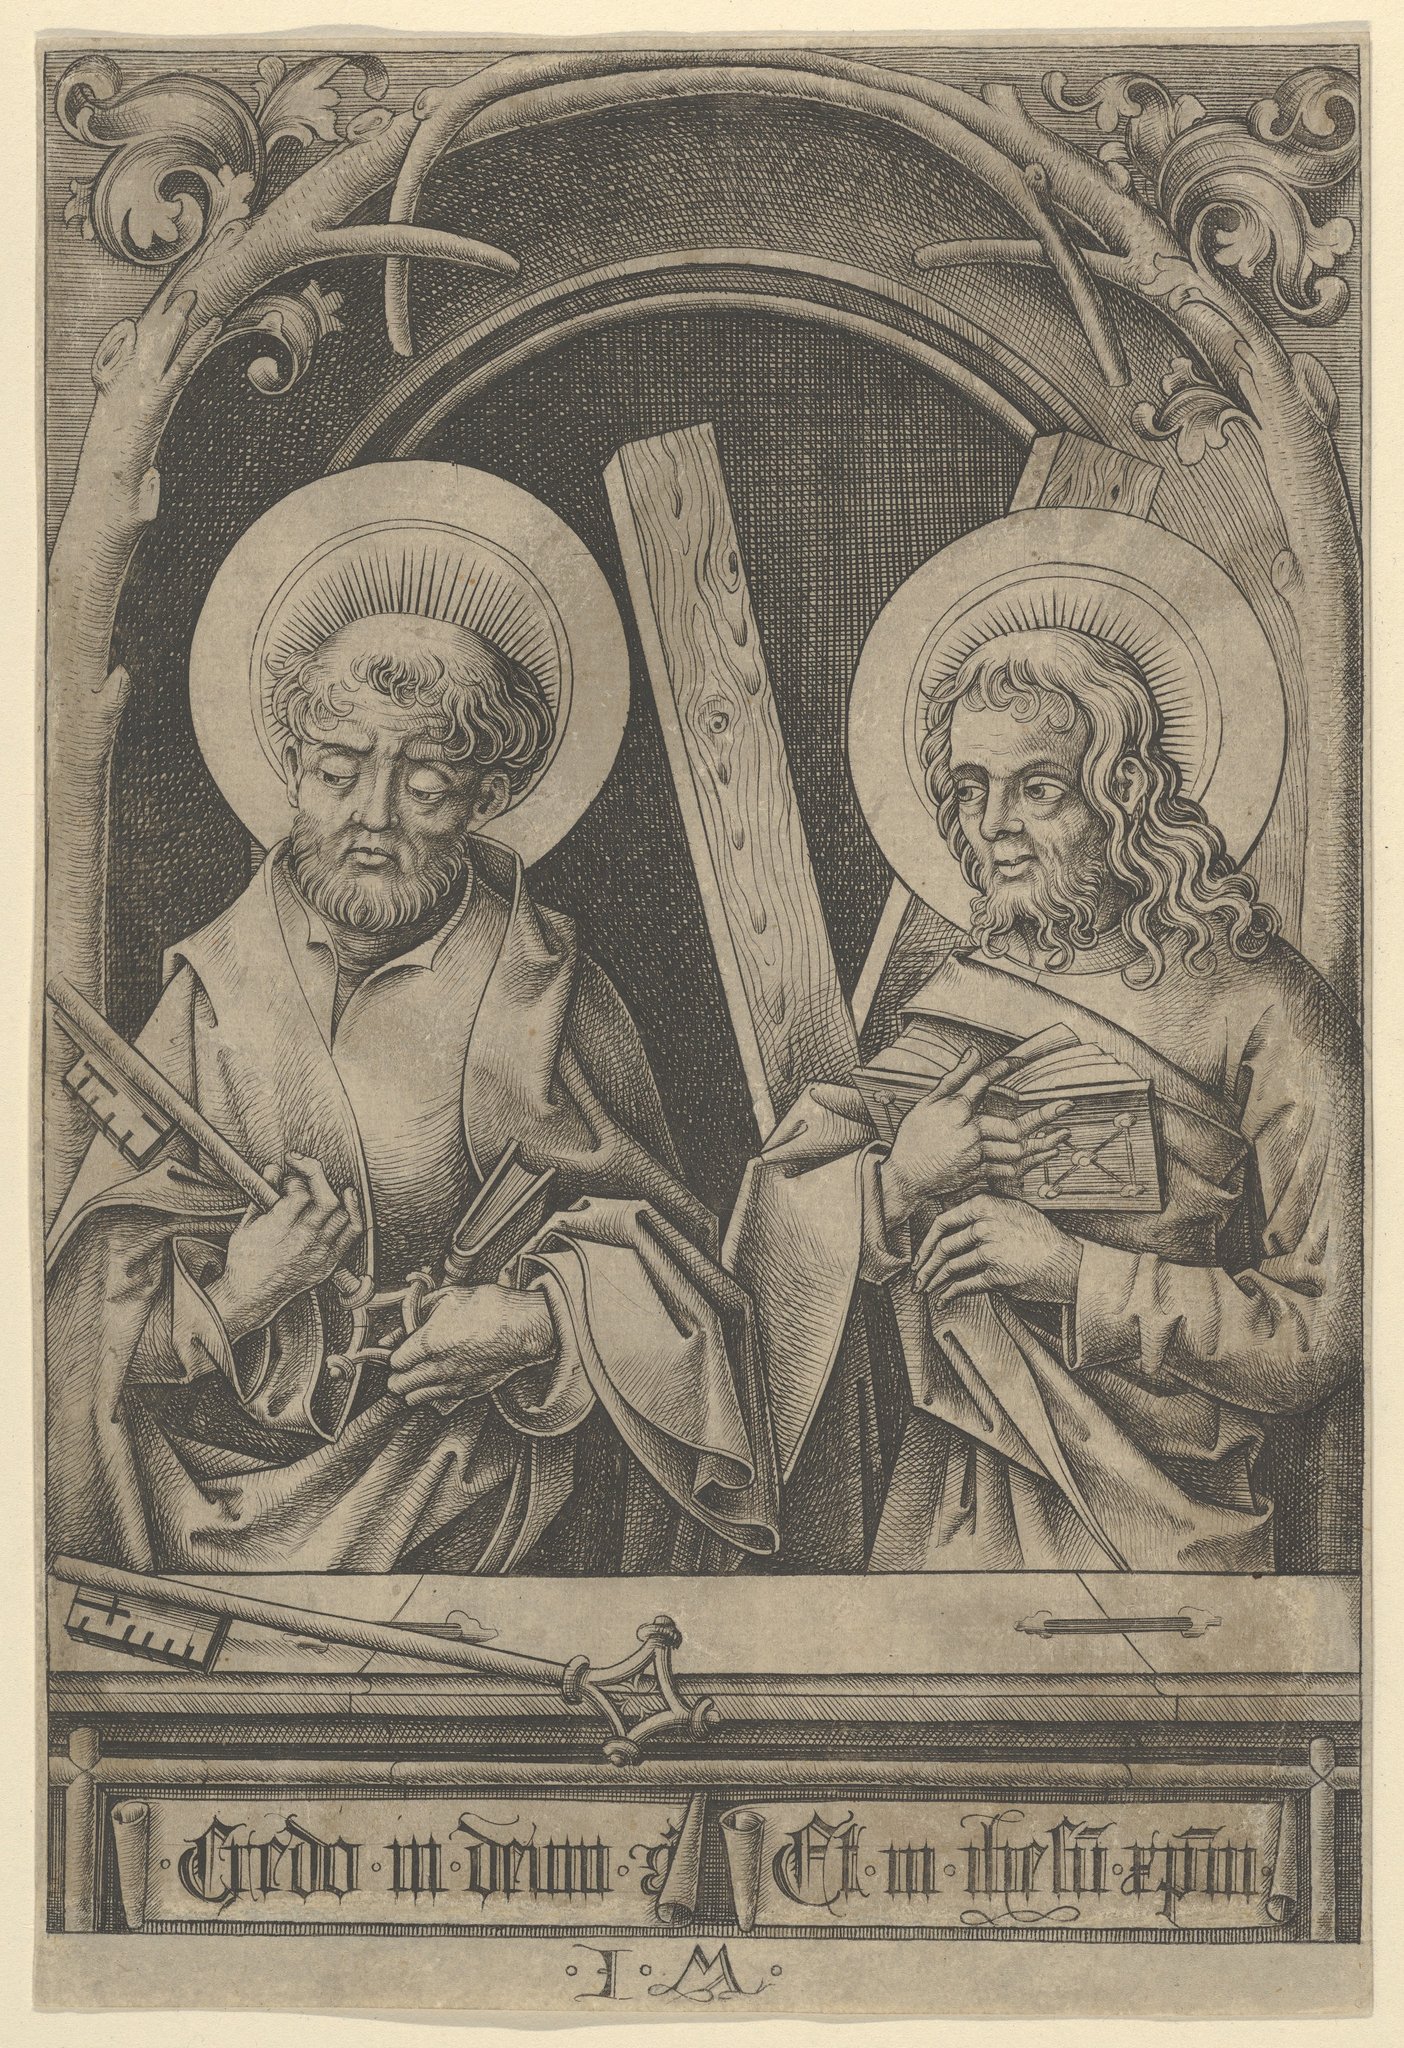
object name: print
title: St. Peter and St. Andrew, from The Apostles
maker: israhel van meckenem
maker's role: artist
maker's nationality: german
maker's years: 1435-1503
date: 1435-1503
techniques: engraving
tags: saint peter,saints